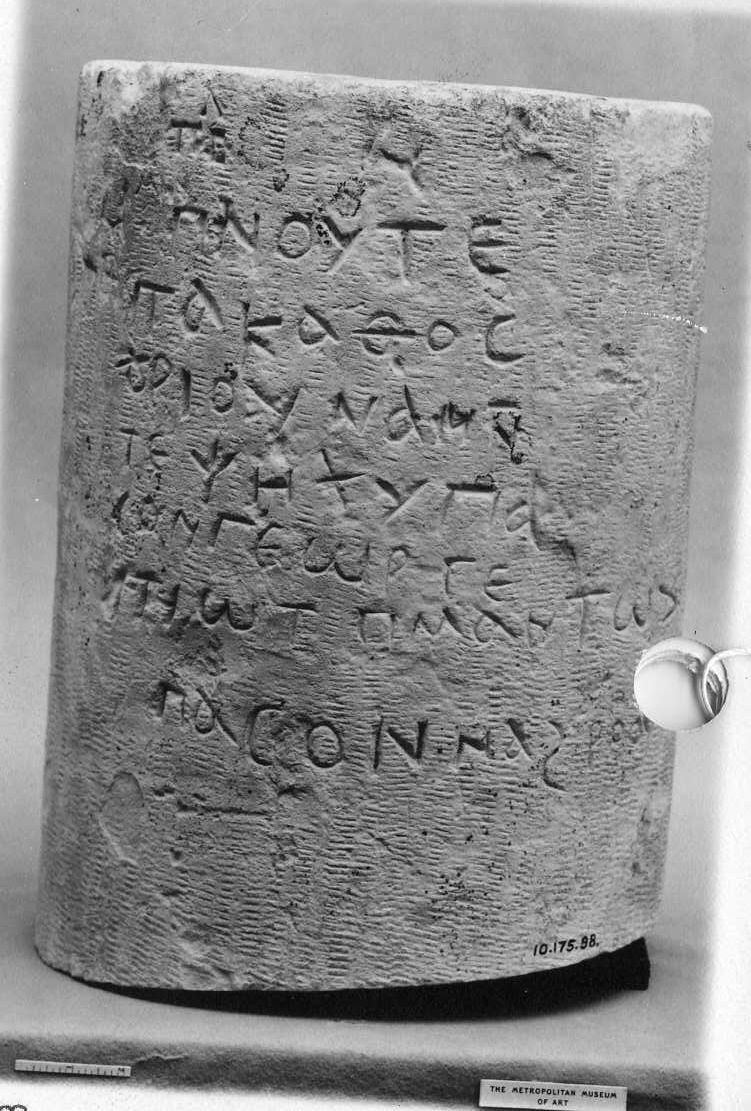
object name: fragment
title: Fragment of an Inscribed Column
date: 501-700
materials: limestone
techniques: incising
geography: egypt